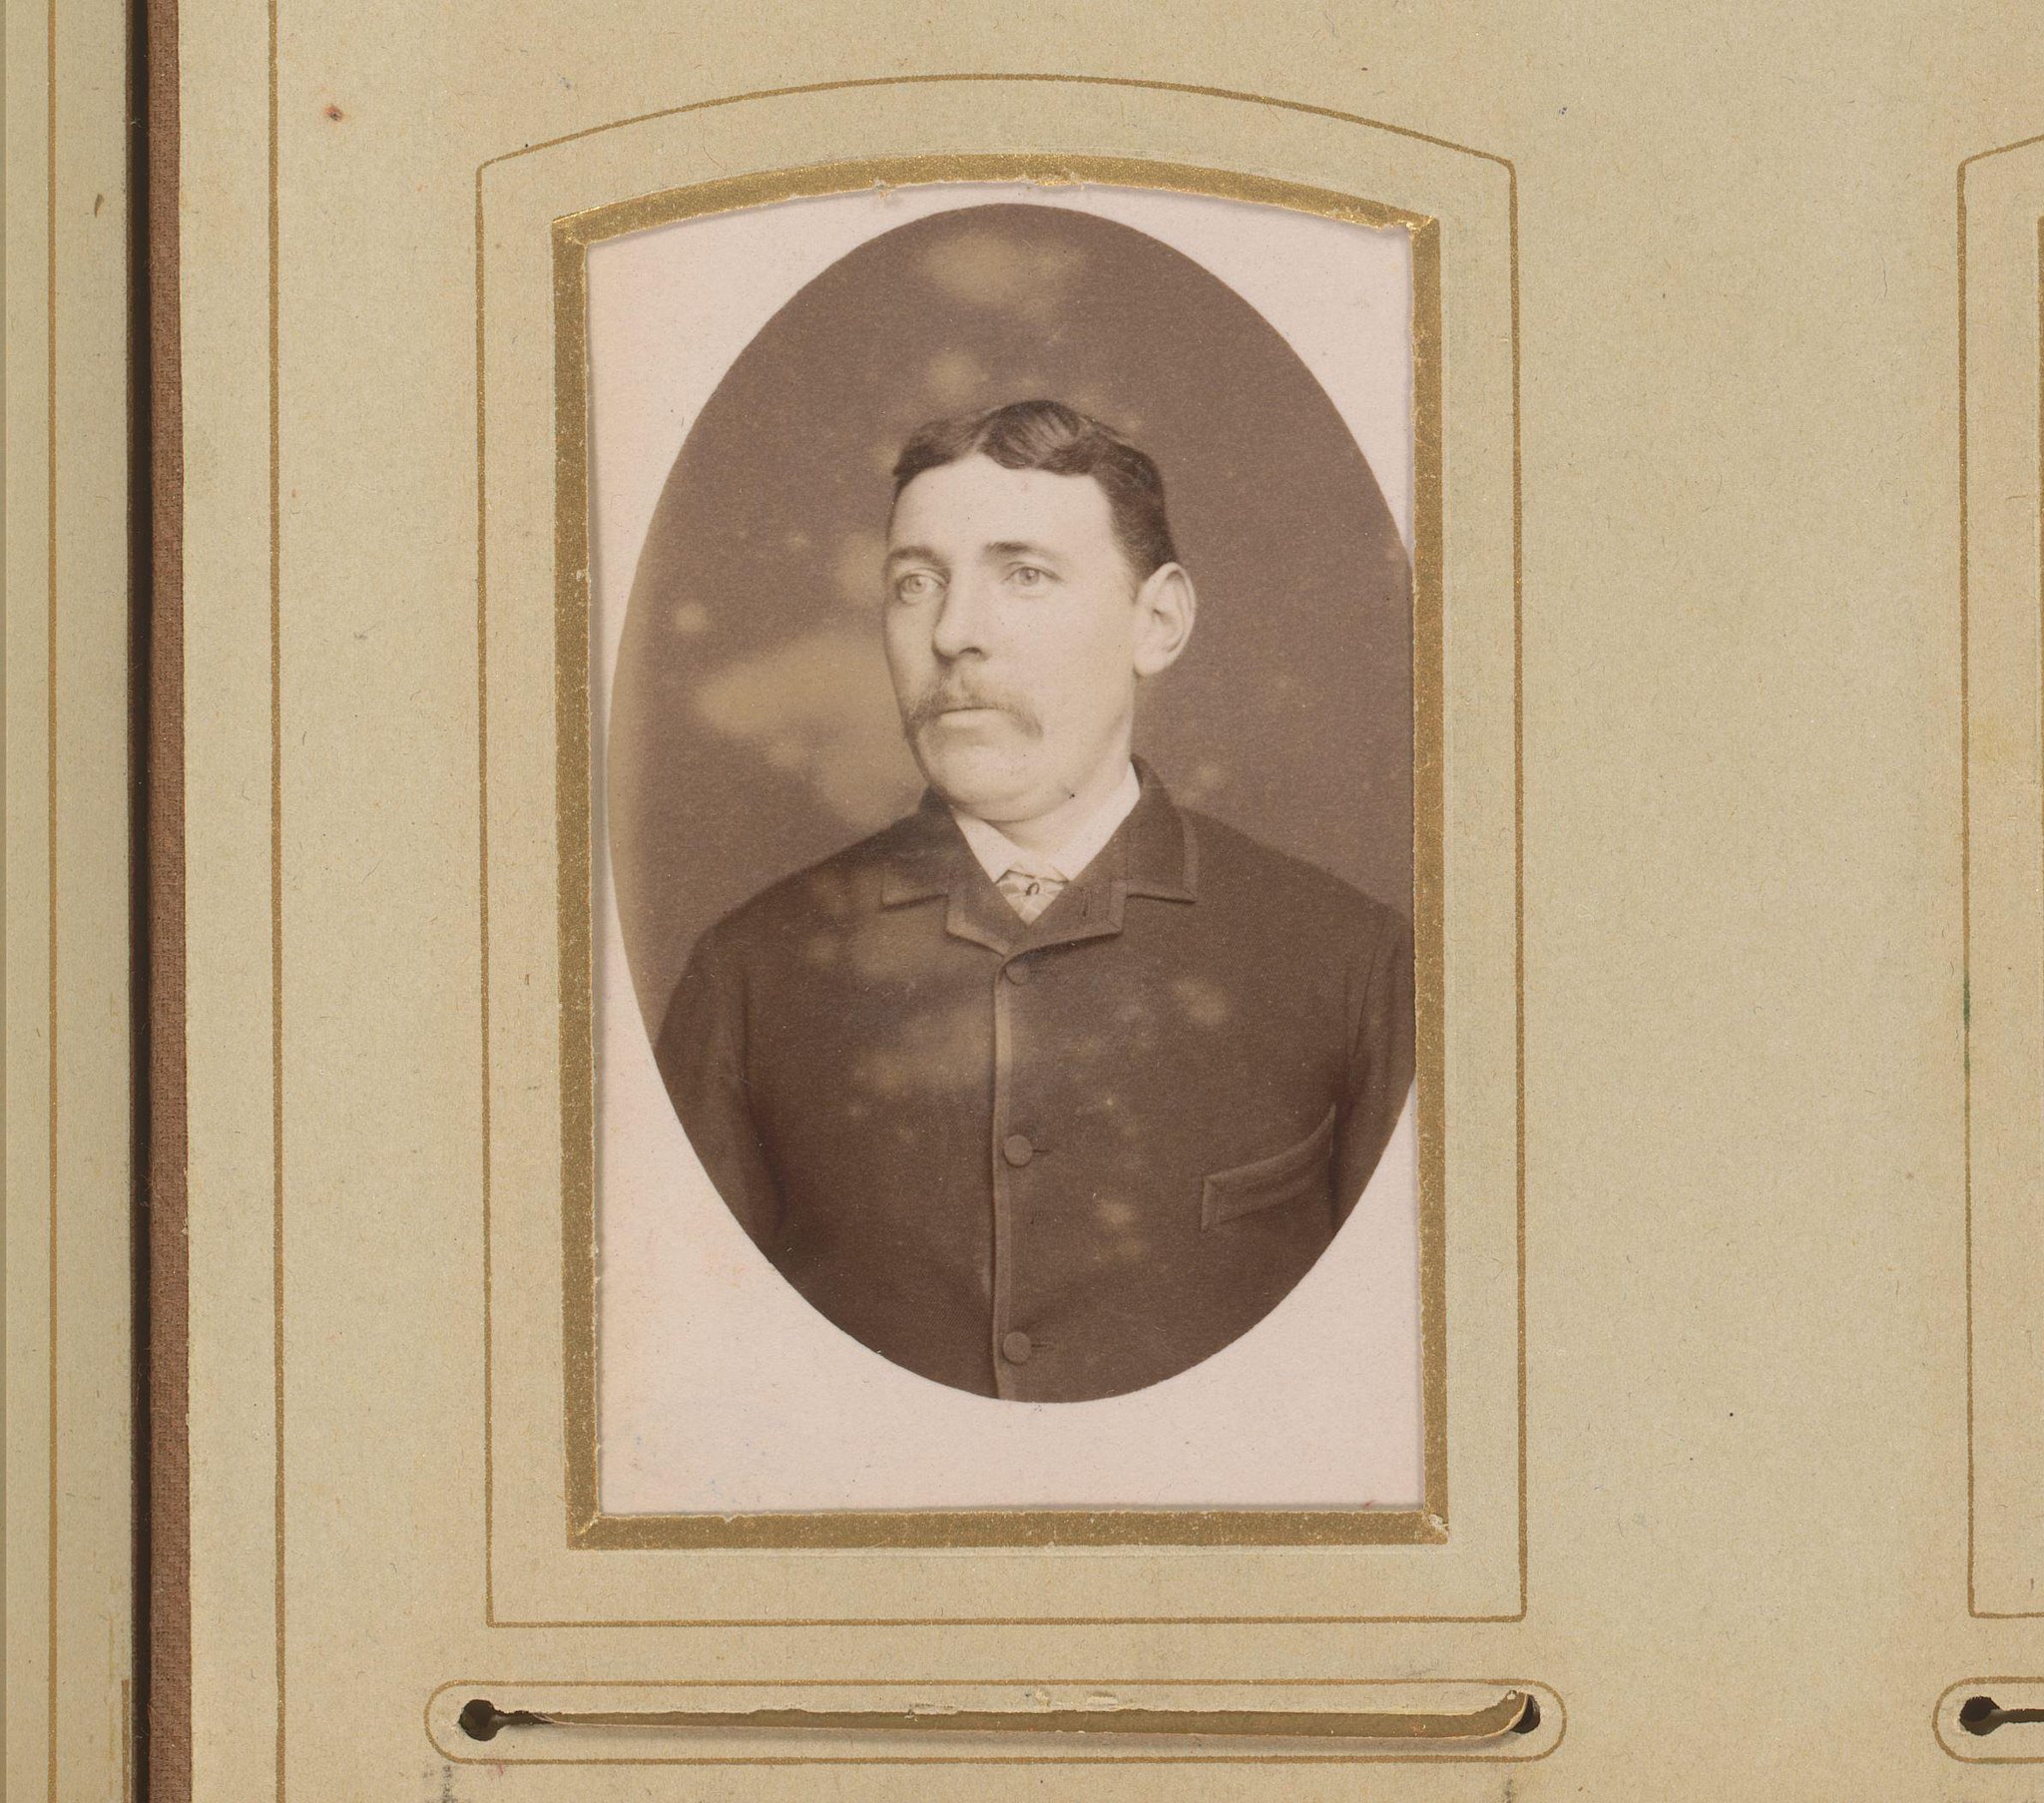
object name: semi enamel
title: Portret van een man met snor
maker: jan hendrik garlinck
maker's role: fotograaf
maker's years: 1833-1887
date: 1882-1887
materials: cardboard, celluloid, photographic support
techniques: albumen print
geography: antwerp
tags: moustache, historical persons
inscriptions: inscription: ‘(...)/ H. Garlinck/ Photographe Artistique/ Anvers/ 11, Rue Carnot 11,/ en face de la zoologie’